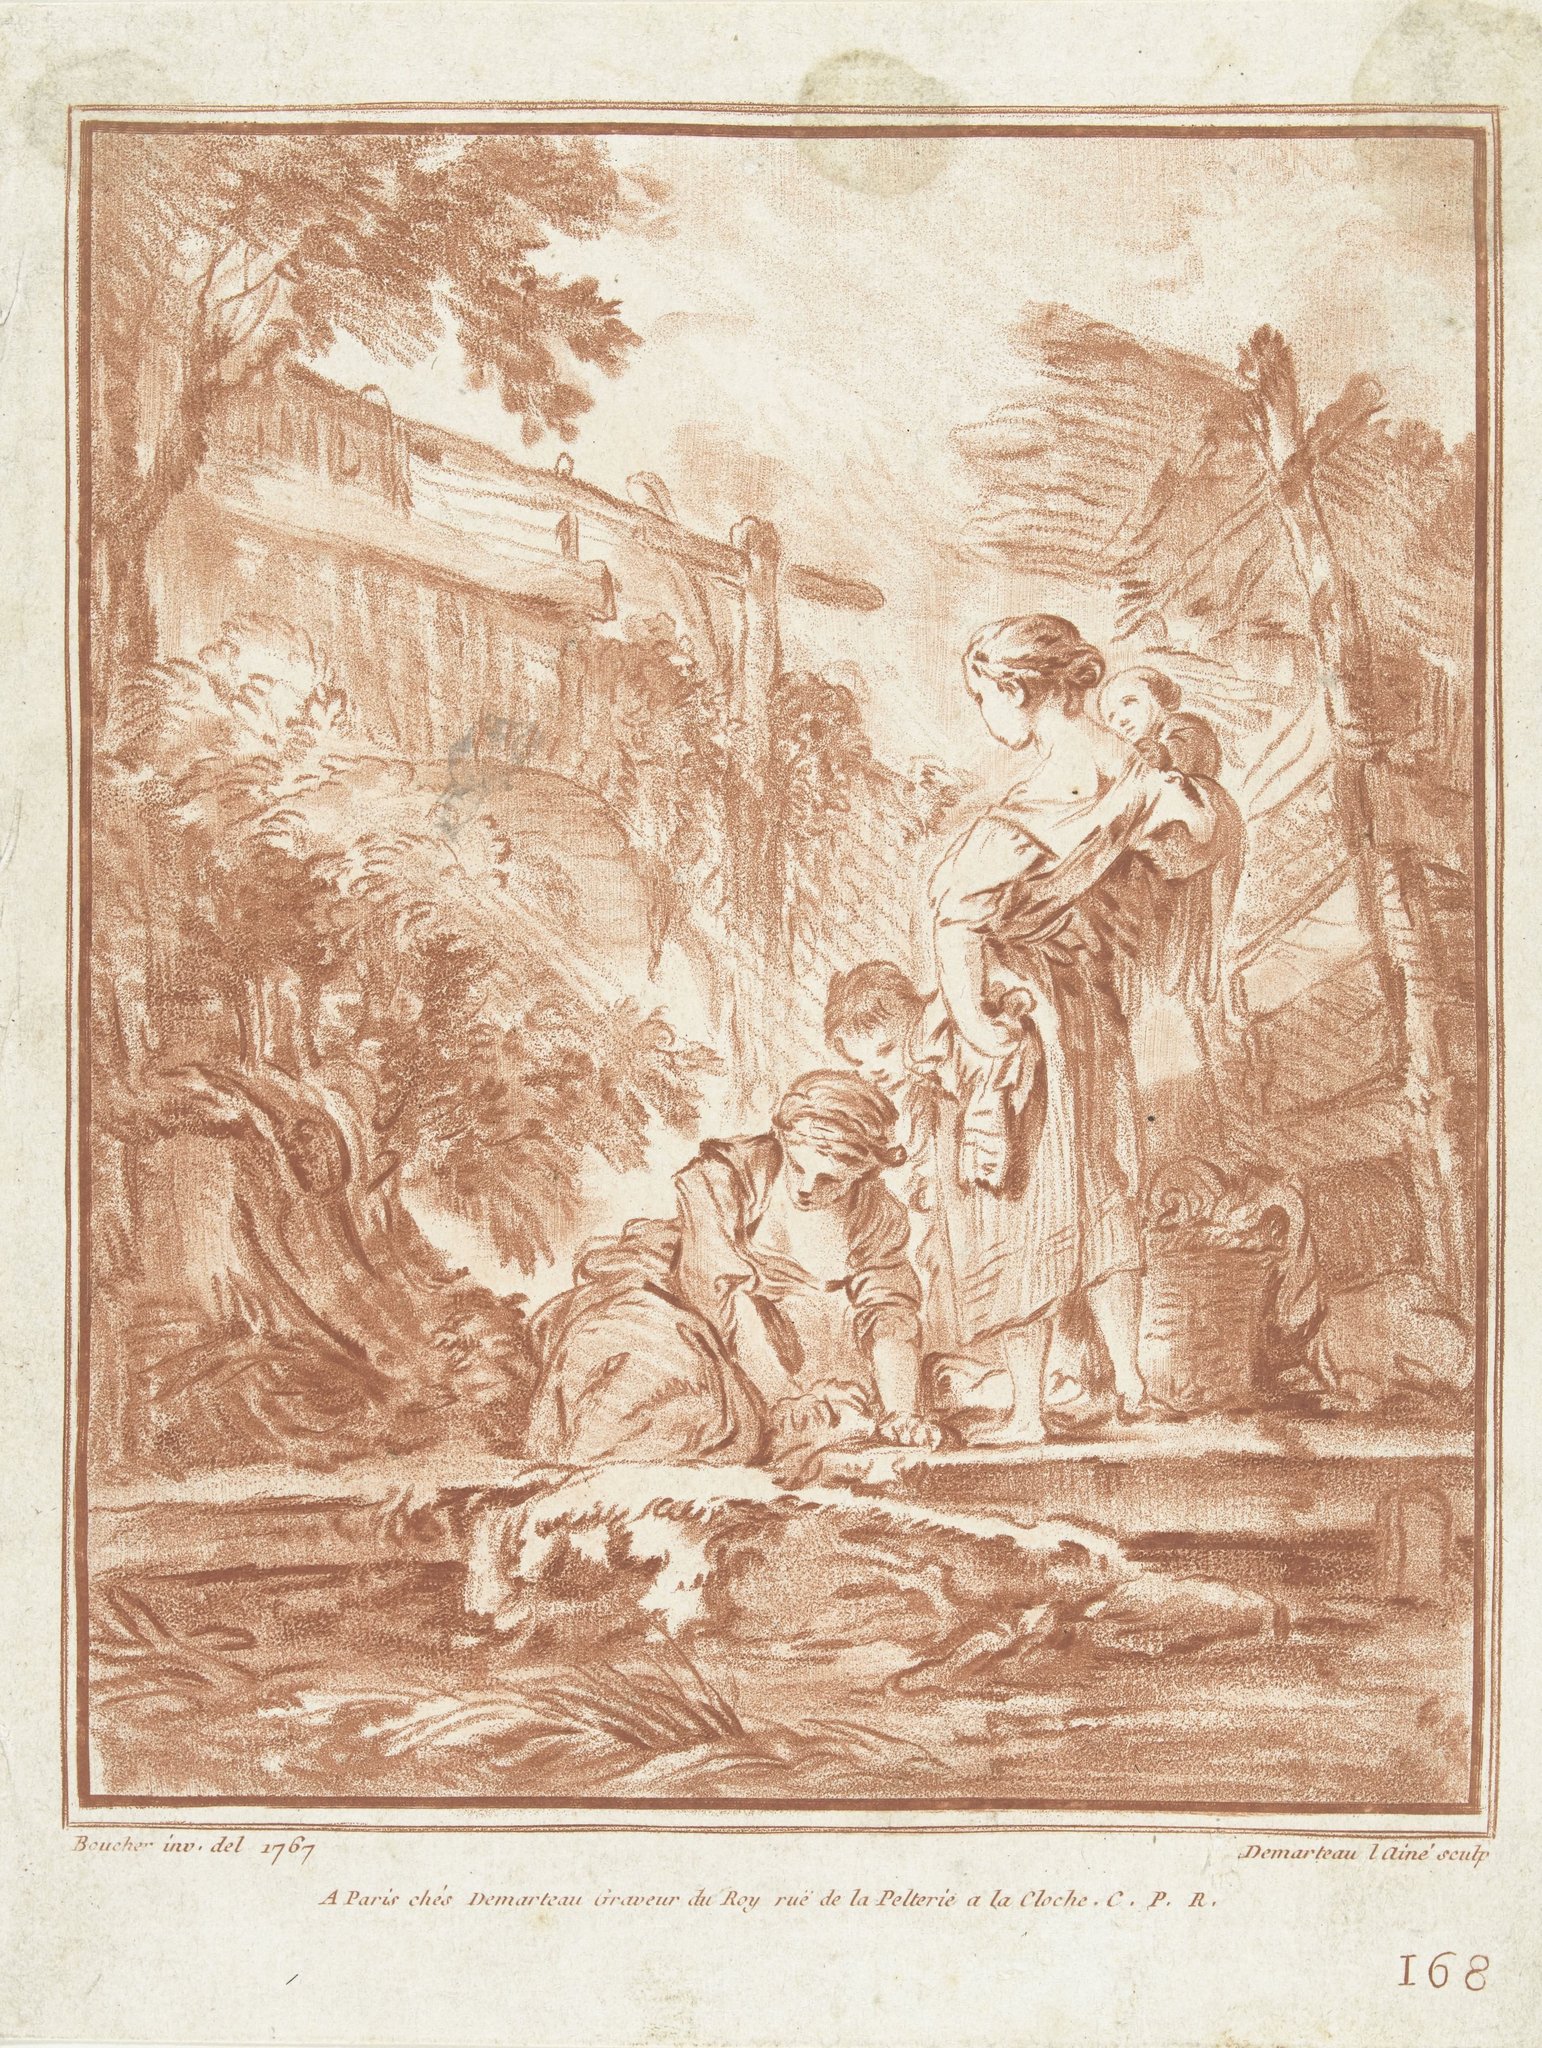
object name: print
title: Wasvrouwen met kinderen bij beek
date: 1767-1776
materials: paper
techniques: printmaking, etching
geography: paris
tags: laundering, building or outbuilding where laundry is done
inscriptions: collector's mark: Lugt 2228